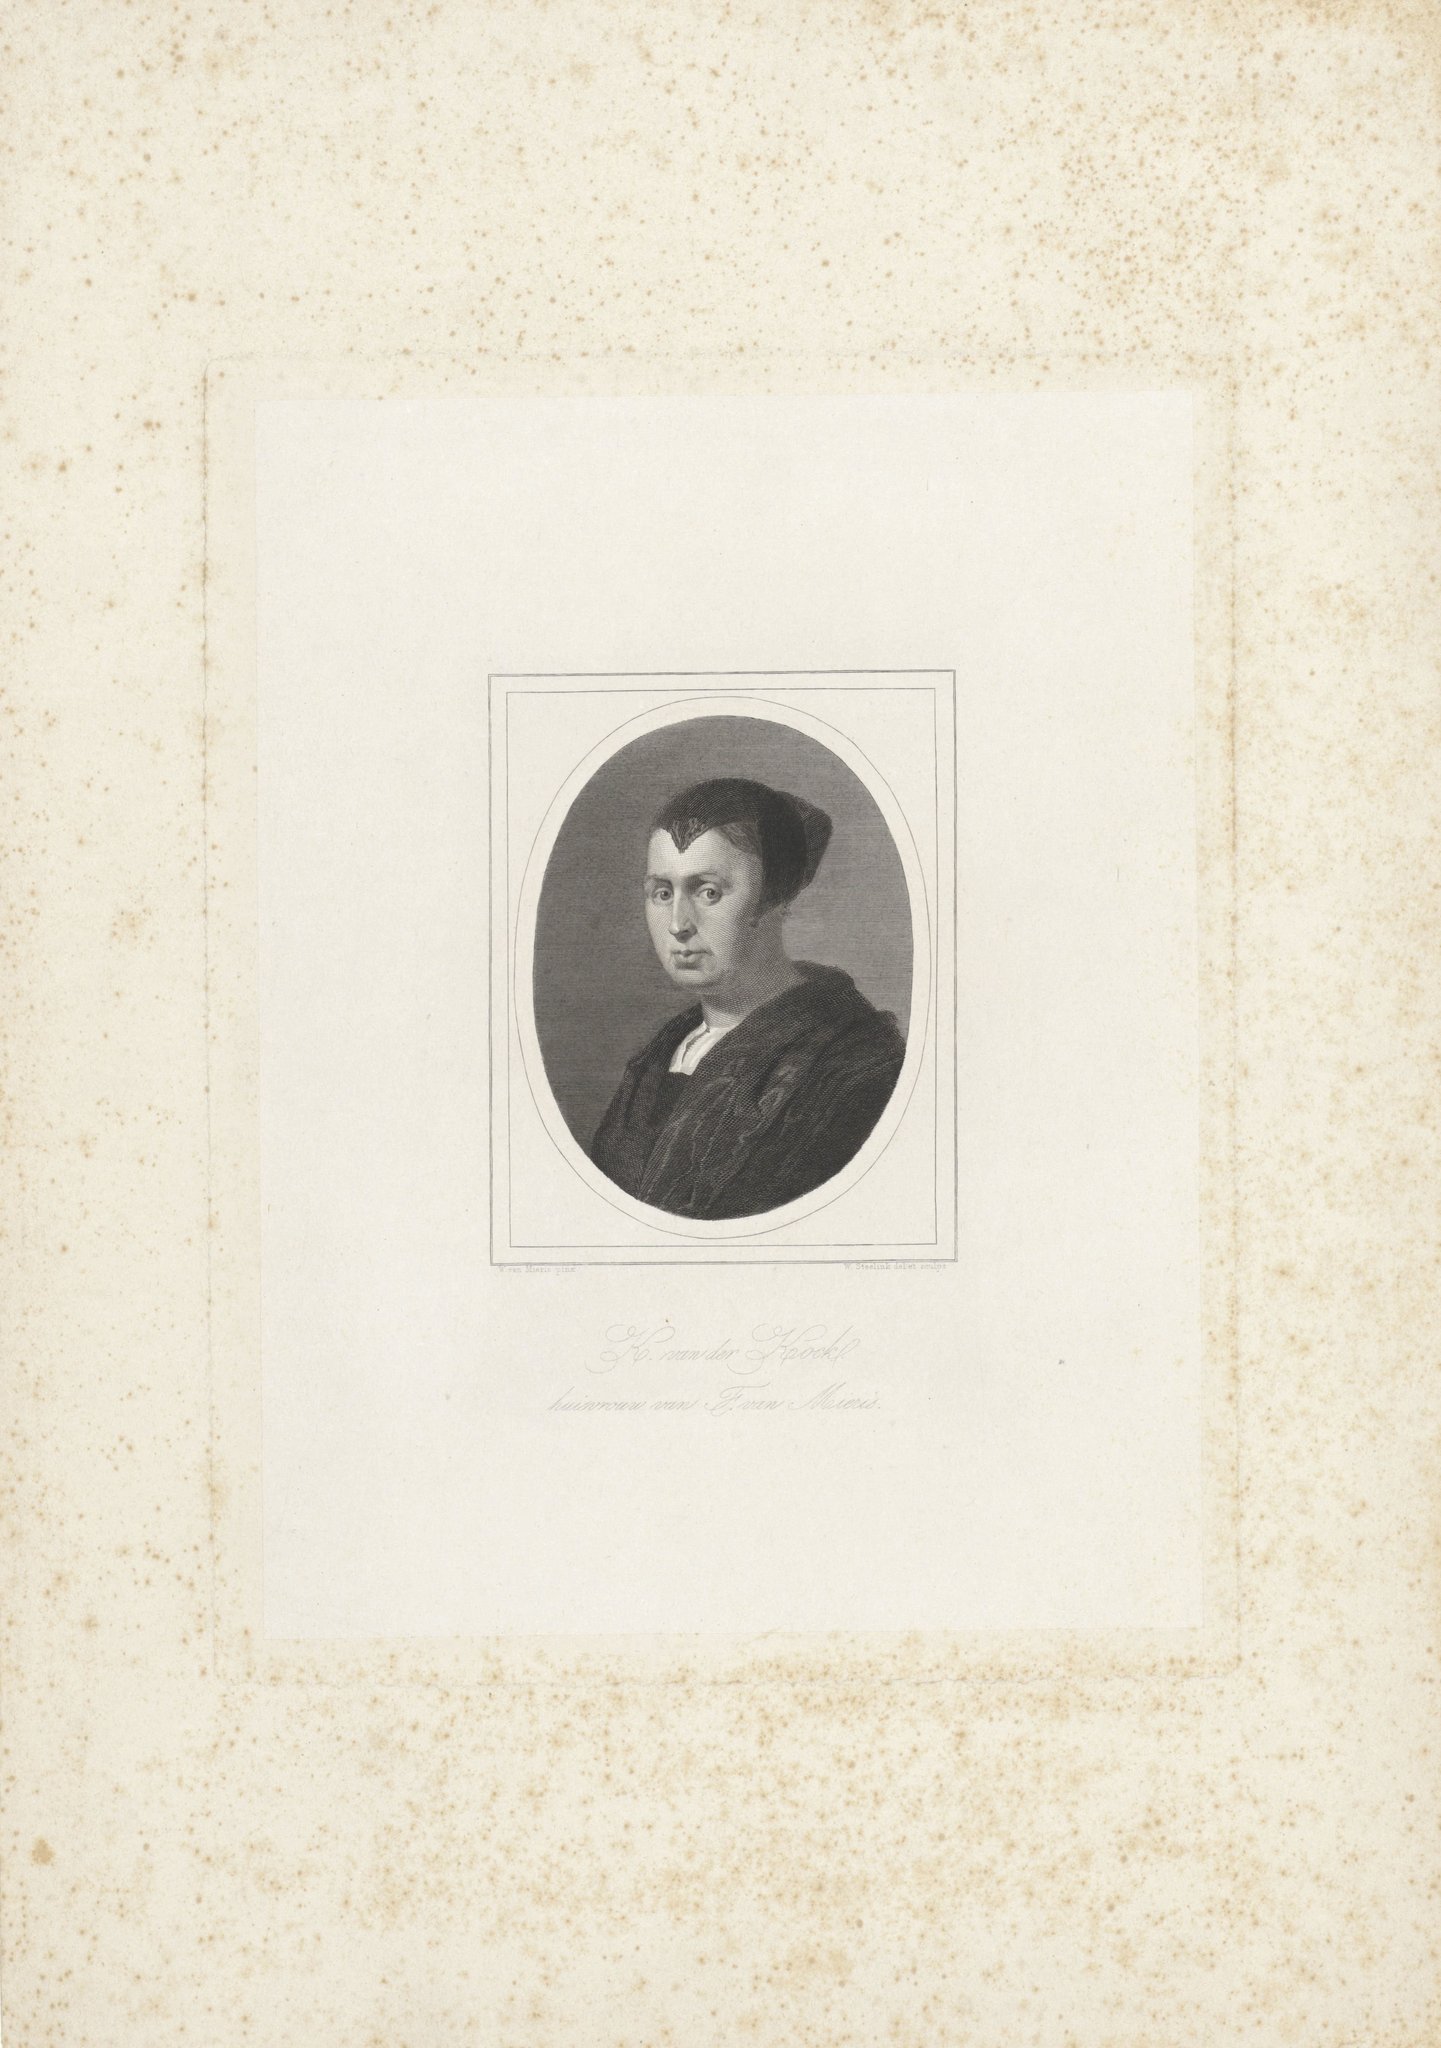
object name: print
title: Portret van Cunera van der Cock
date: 1836-1913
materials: paper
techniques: engraving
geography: amsterdam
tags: cunera van der cock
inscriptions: collector's mark: Lugt 2228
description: Portret van Cunera van der Cock, echtgenote van schilder Frans van Mieris (I).